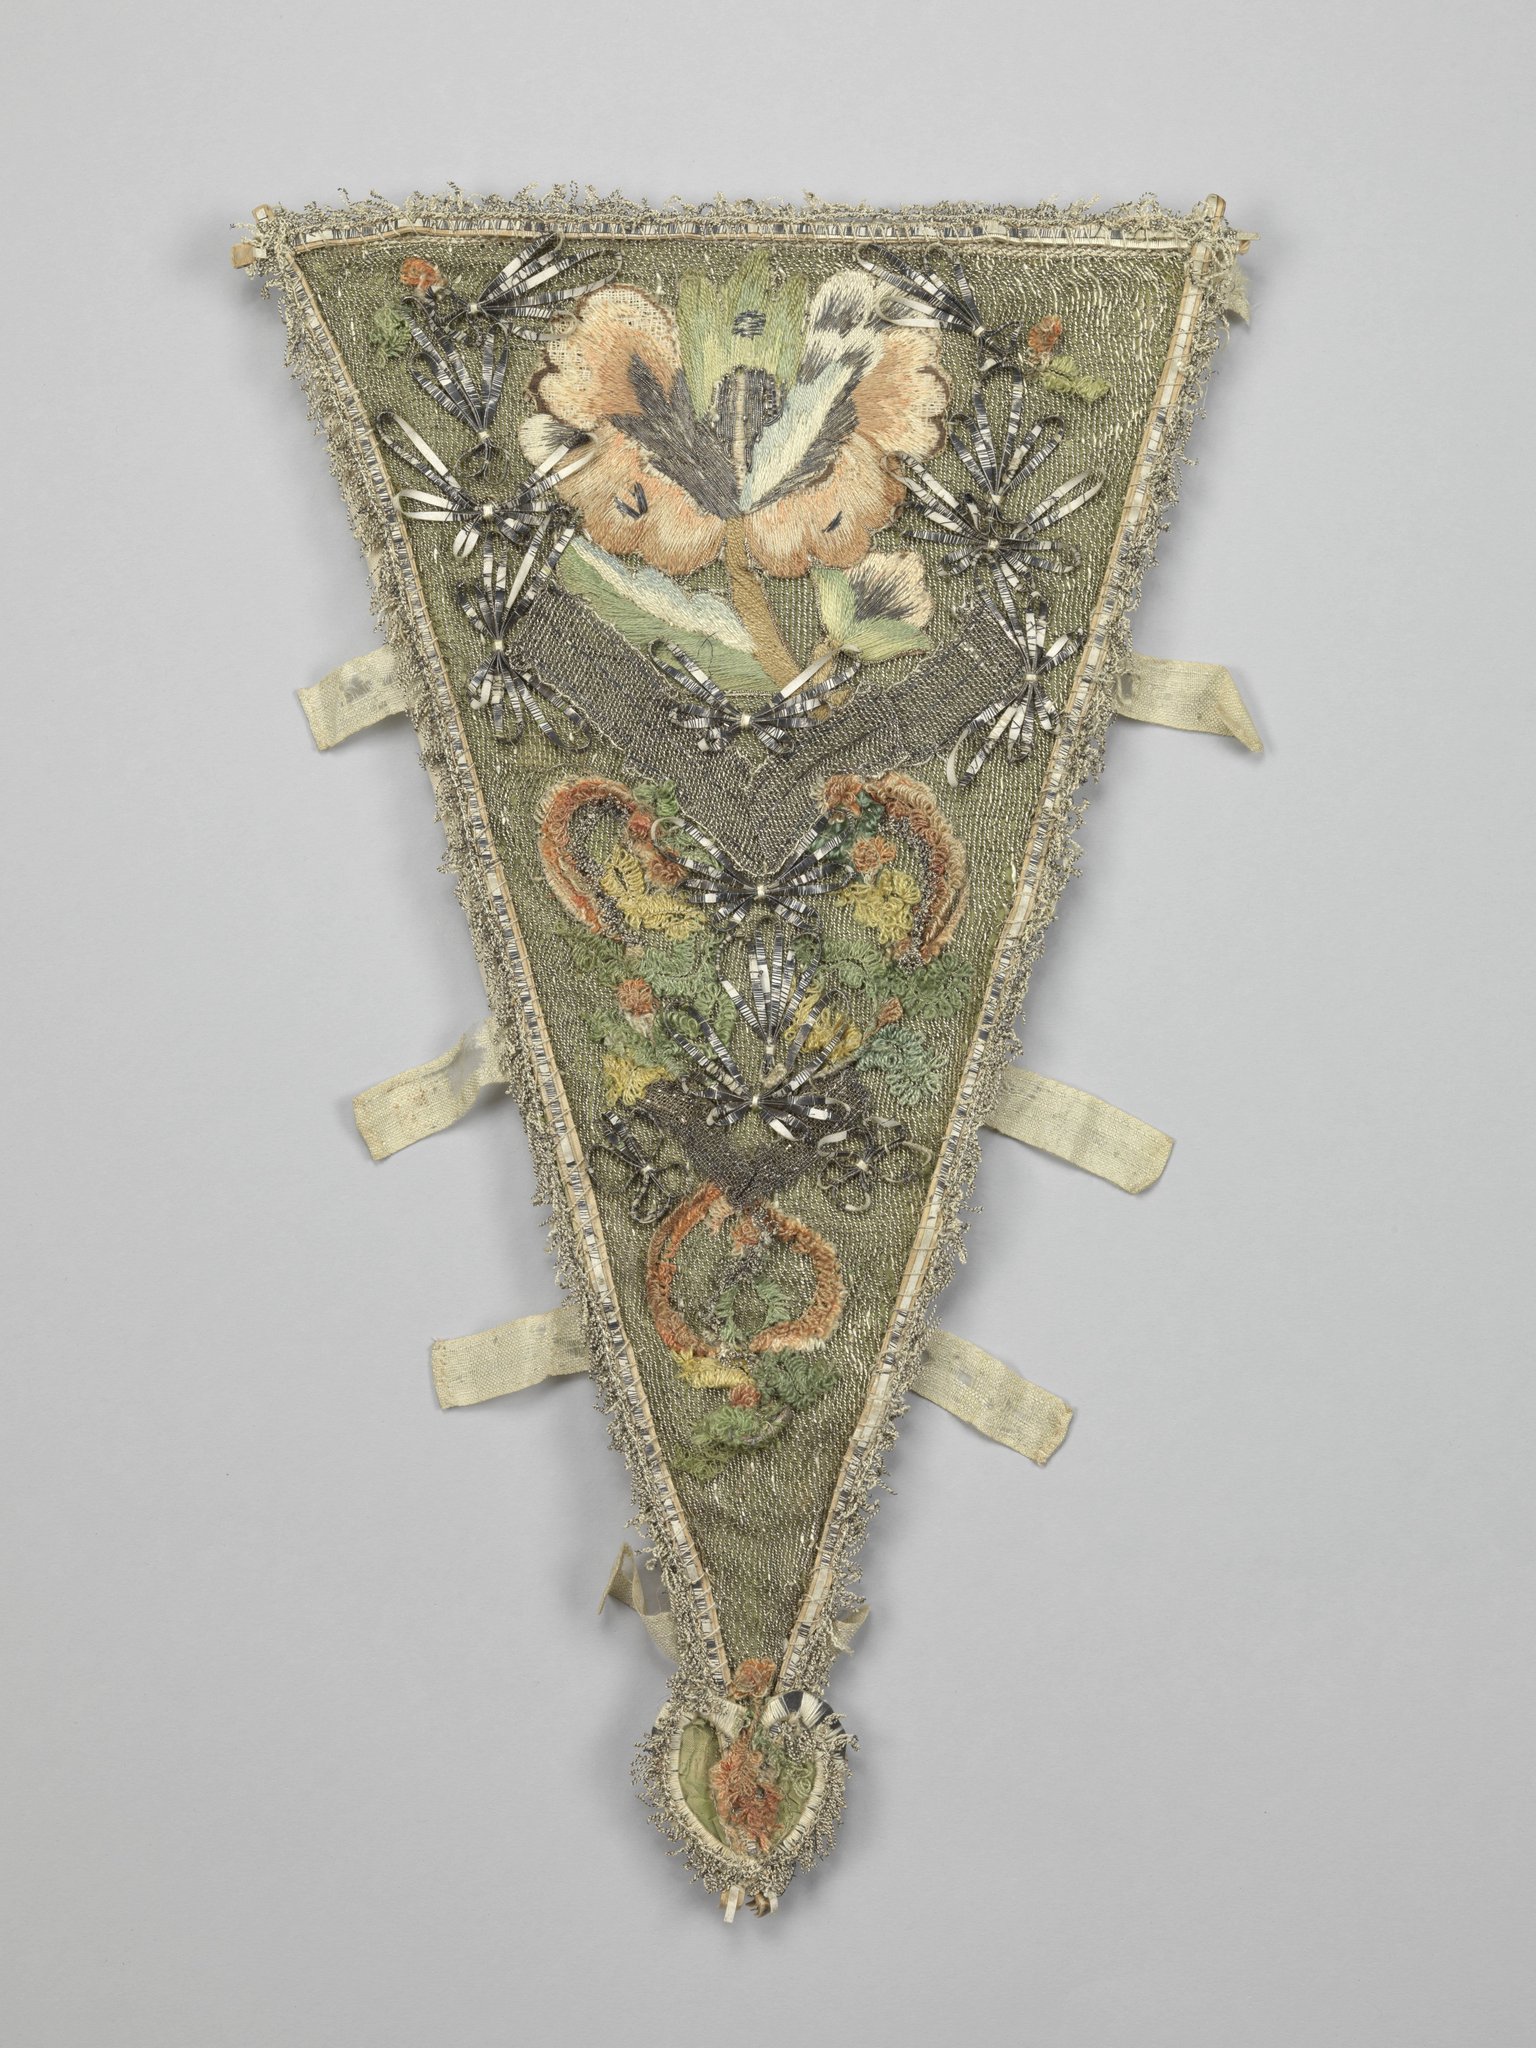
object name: borstlap, maagstuk, borststuk, devant de gorge, plastron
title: Driehoekig borststuk van lichtgroene zijde, versierd met zilvergaas waarop bloemenappliques van veelkleurige chenille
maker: Anonymous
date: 1750-1775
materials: textile, linen, paper, silk, thread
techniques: knotting, weave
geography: netherlands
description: Driehoekig borststuk van lichtgroene satijn gevoerd met naturel linnen. Aan voorkant versierd met een gaasachtig weefsel van zilverdraad in platbinding waarop appliques in oranje, roze, witte en gele chenille (bloemen) met groene blaadjes van chenille. Versiering: bovenaan middenin een applique van een bloem in oranje, roze, crème, blauwe en groene zijde en zilverdraad in ingrijpsteek. De bloem heeft een bruin beige steel en groen, beige, blauw met roze, zilver en licht- en donkergroen blad. Ter weerszijden van de bloemen strikken van stroken dit papier omwonden met zilverdraad om een zijden kern. Onder de bloemenapplique een V-vormig ornament van losgeweven band van zilverdraar om een zijden kern (2 cm breed). Hieronder een symmetrisch opgebouwd ornament met strikken in het midden en florale chenille appliques aan weerszijden. De devant-de-gorge eindigt in een hartvormige punt waarin roze en groene chenille. Het geel is afgezet met een rand dik papier (0.5 cm) omwonden met zilverdraad met een zijden kern en een zilveren franje. Aan weerszijden oorspronkelijk vijf zijden flapjes van 5.5 cm waarmee de deavnt-de-gorge aan de japon werd gespeld.